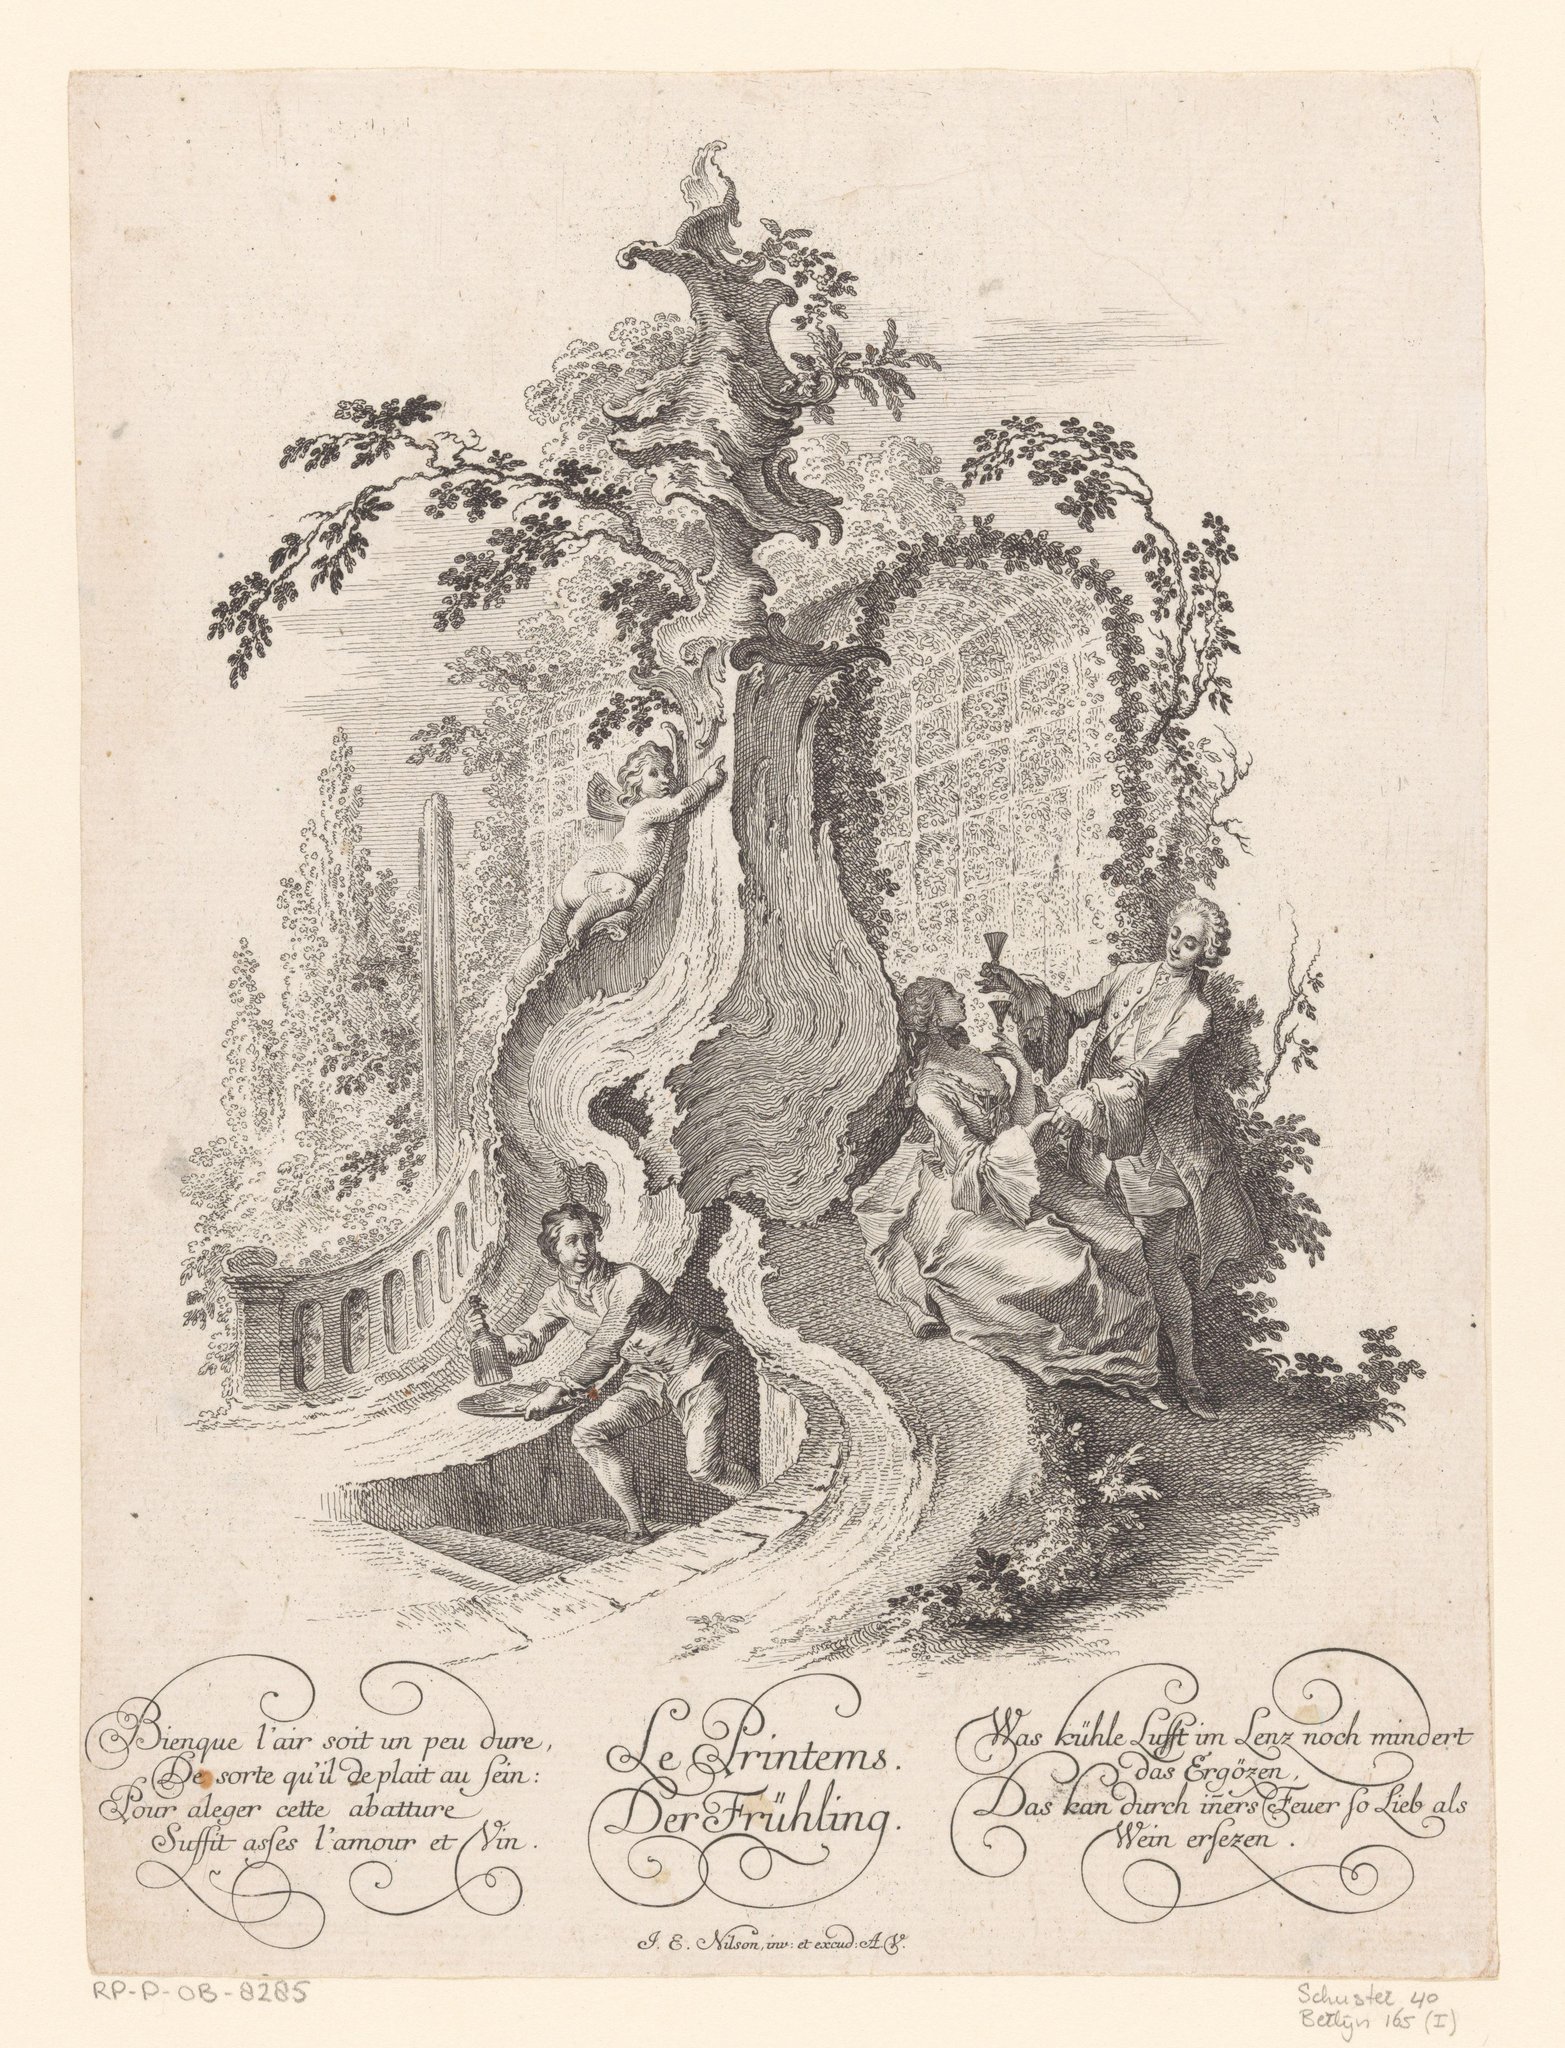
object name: print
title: Le Printems / Der Frühling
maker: johann esaias nilson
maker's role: draughtsman, print maker, publisher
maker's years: 1721-1788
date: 1731-1788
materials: paper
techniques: etching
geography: augsburg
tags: wine ~ alcoholic drinks (+ taking (particular) foodstuffs: eating, drinking, smoking, chewing, etc.), spring, 'ver'; 'primavera' (ripa) (+ with scenes showing human occupations ~ seasons and months)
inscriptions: collector's mark: Lugt 2228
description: Een man en een vrouw zitten in een tuin voor een loofgang en drinken wijn. Links van hen komt vanuit een kelder een bediende met een fles drank een trap opgelopen. Daarboven bevindt zich een rocaille ornament met vaas en putto. In de ondermarge tweemaal een vierregelige Franse en Duitse tekst.